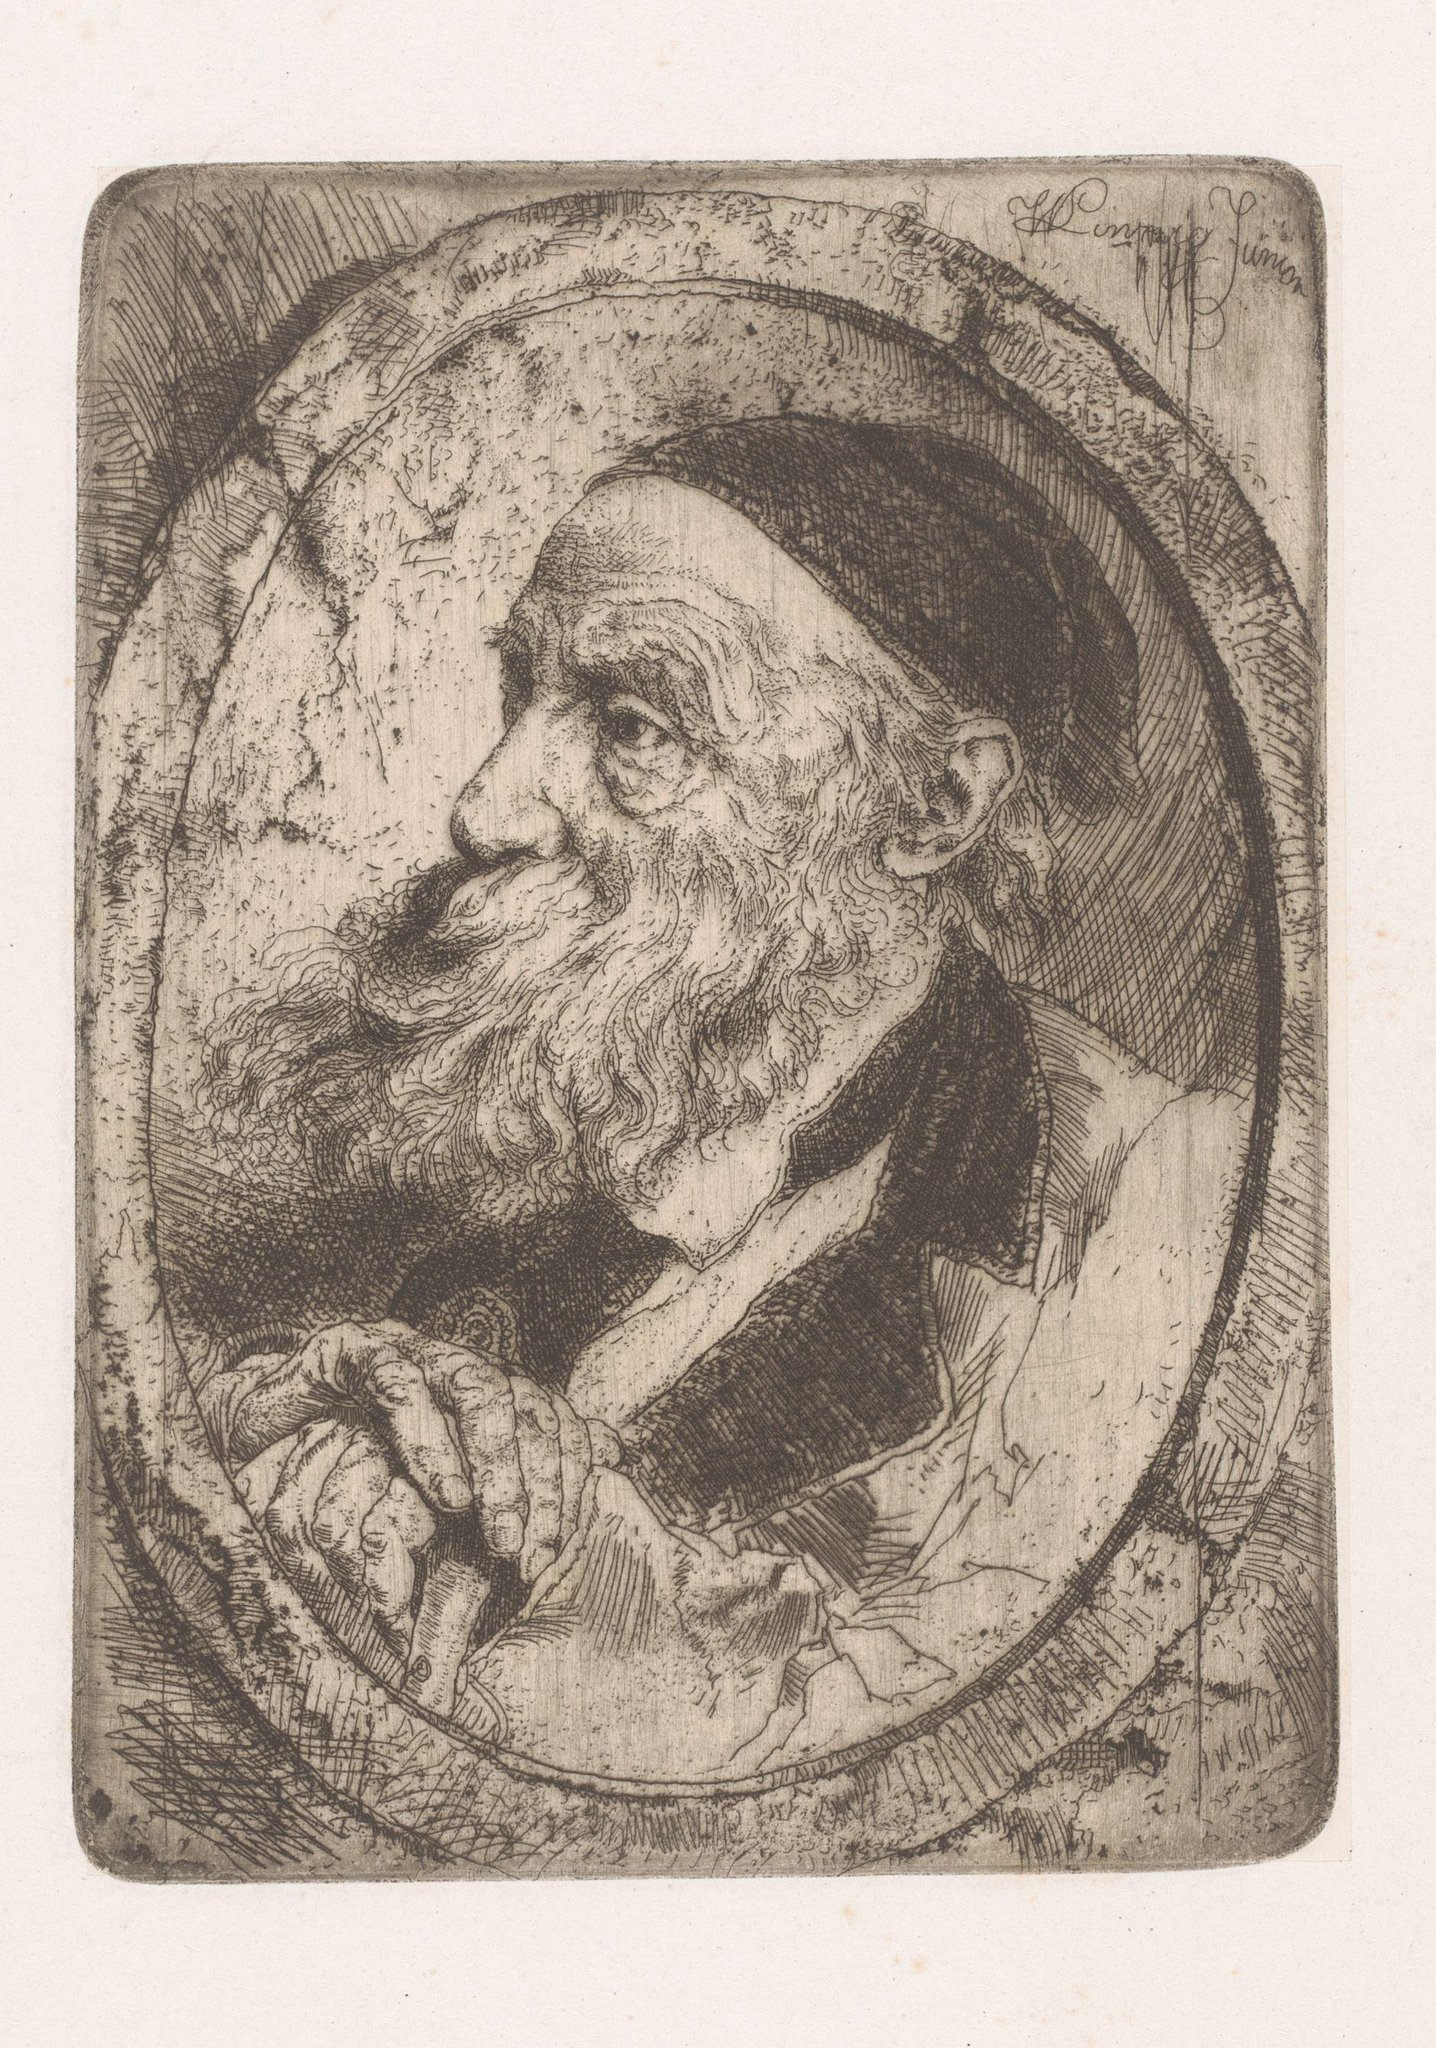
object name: print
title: Portret van een onbekende oude man met zijn handen op een wandelstok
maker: willem linnig (ii)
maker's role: print maker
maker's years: 1842-1890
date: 1852-1890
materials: paper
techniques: drypoint, etching, intaglio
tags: anonymous historical person portrayed alone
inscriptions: collector's mark: Lugt 2228